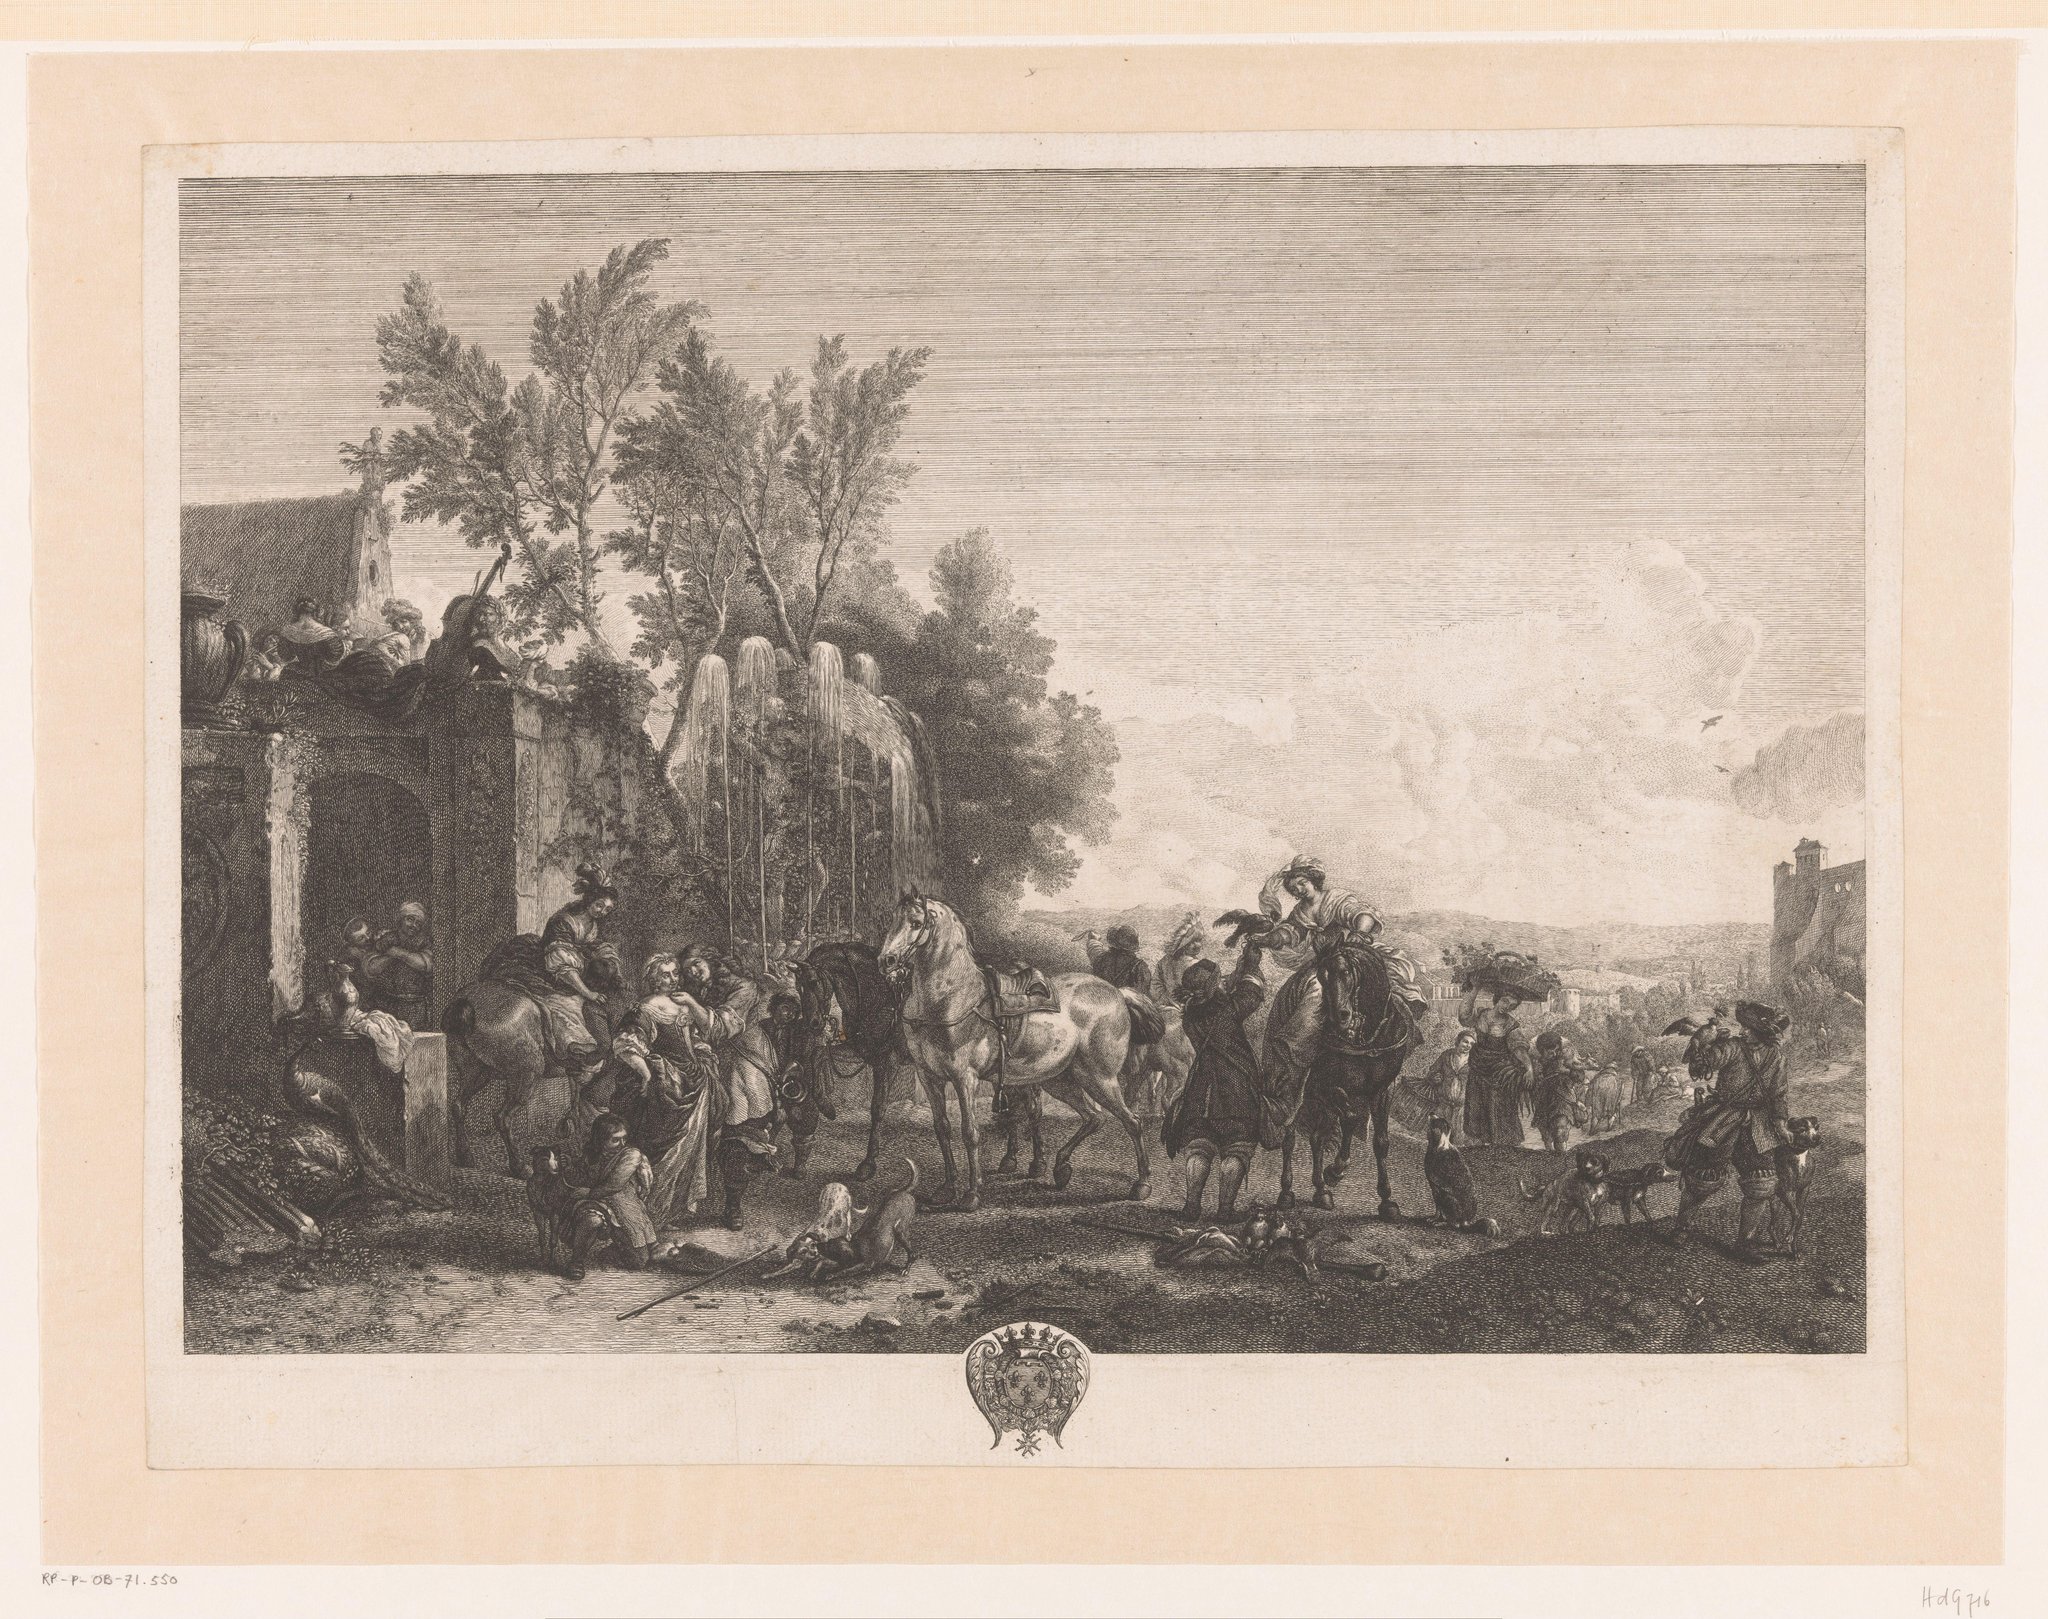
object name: print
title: Oeuvres de Ph.pe Wouwermans Hollandois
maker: jean moyreau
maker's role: print maker, publisher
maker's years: 1690-1762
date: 1733-1762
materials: paper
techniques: engraving, etching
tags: predatory birds: falcon, bird hunting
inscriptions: inscription: ‘f 330-’, collector's mark: Lugt 240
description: Maakt deel uit van een serie van 89 prenten te dateren tussen ca. 1733-1762, naar het geschilderde oeuvre van Philips Wouwerman. Dit betreft plaat 30.